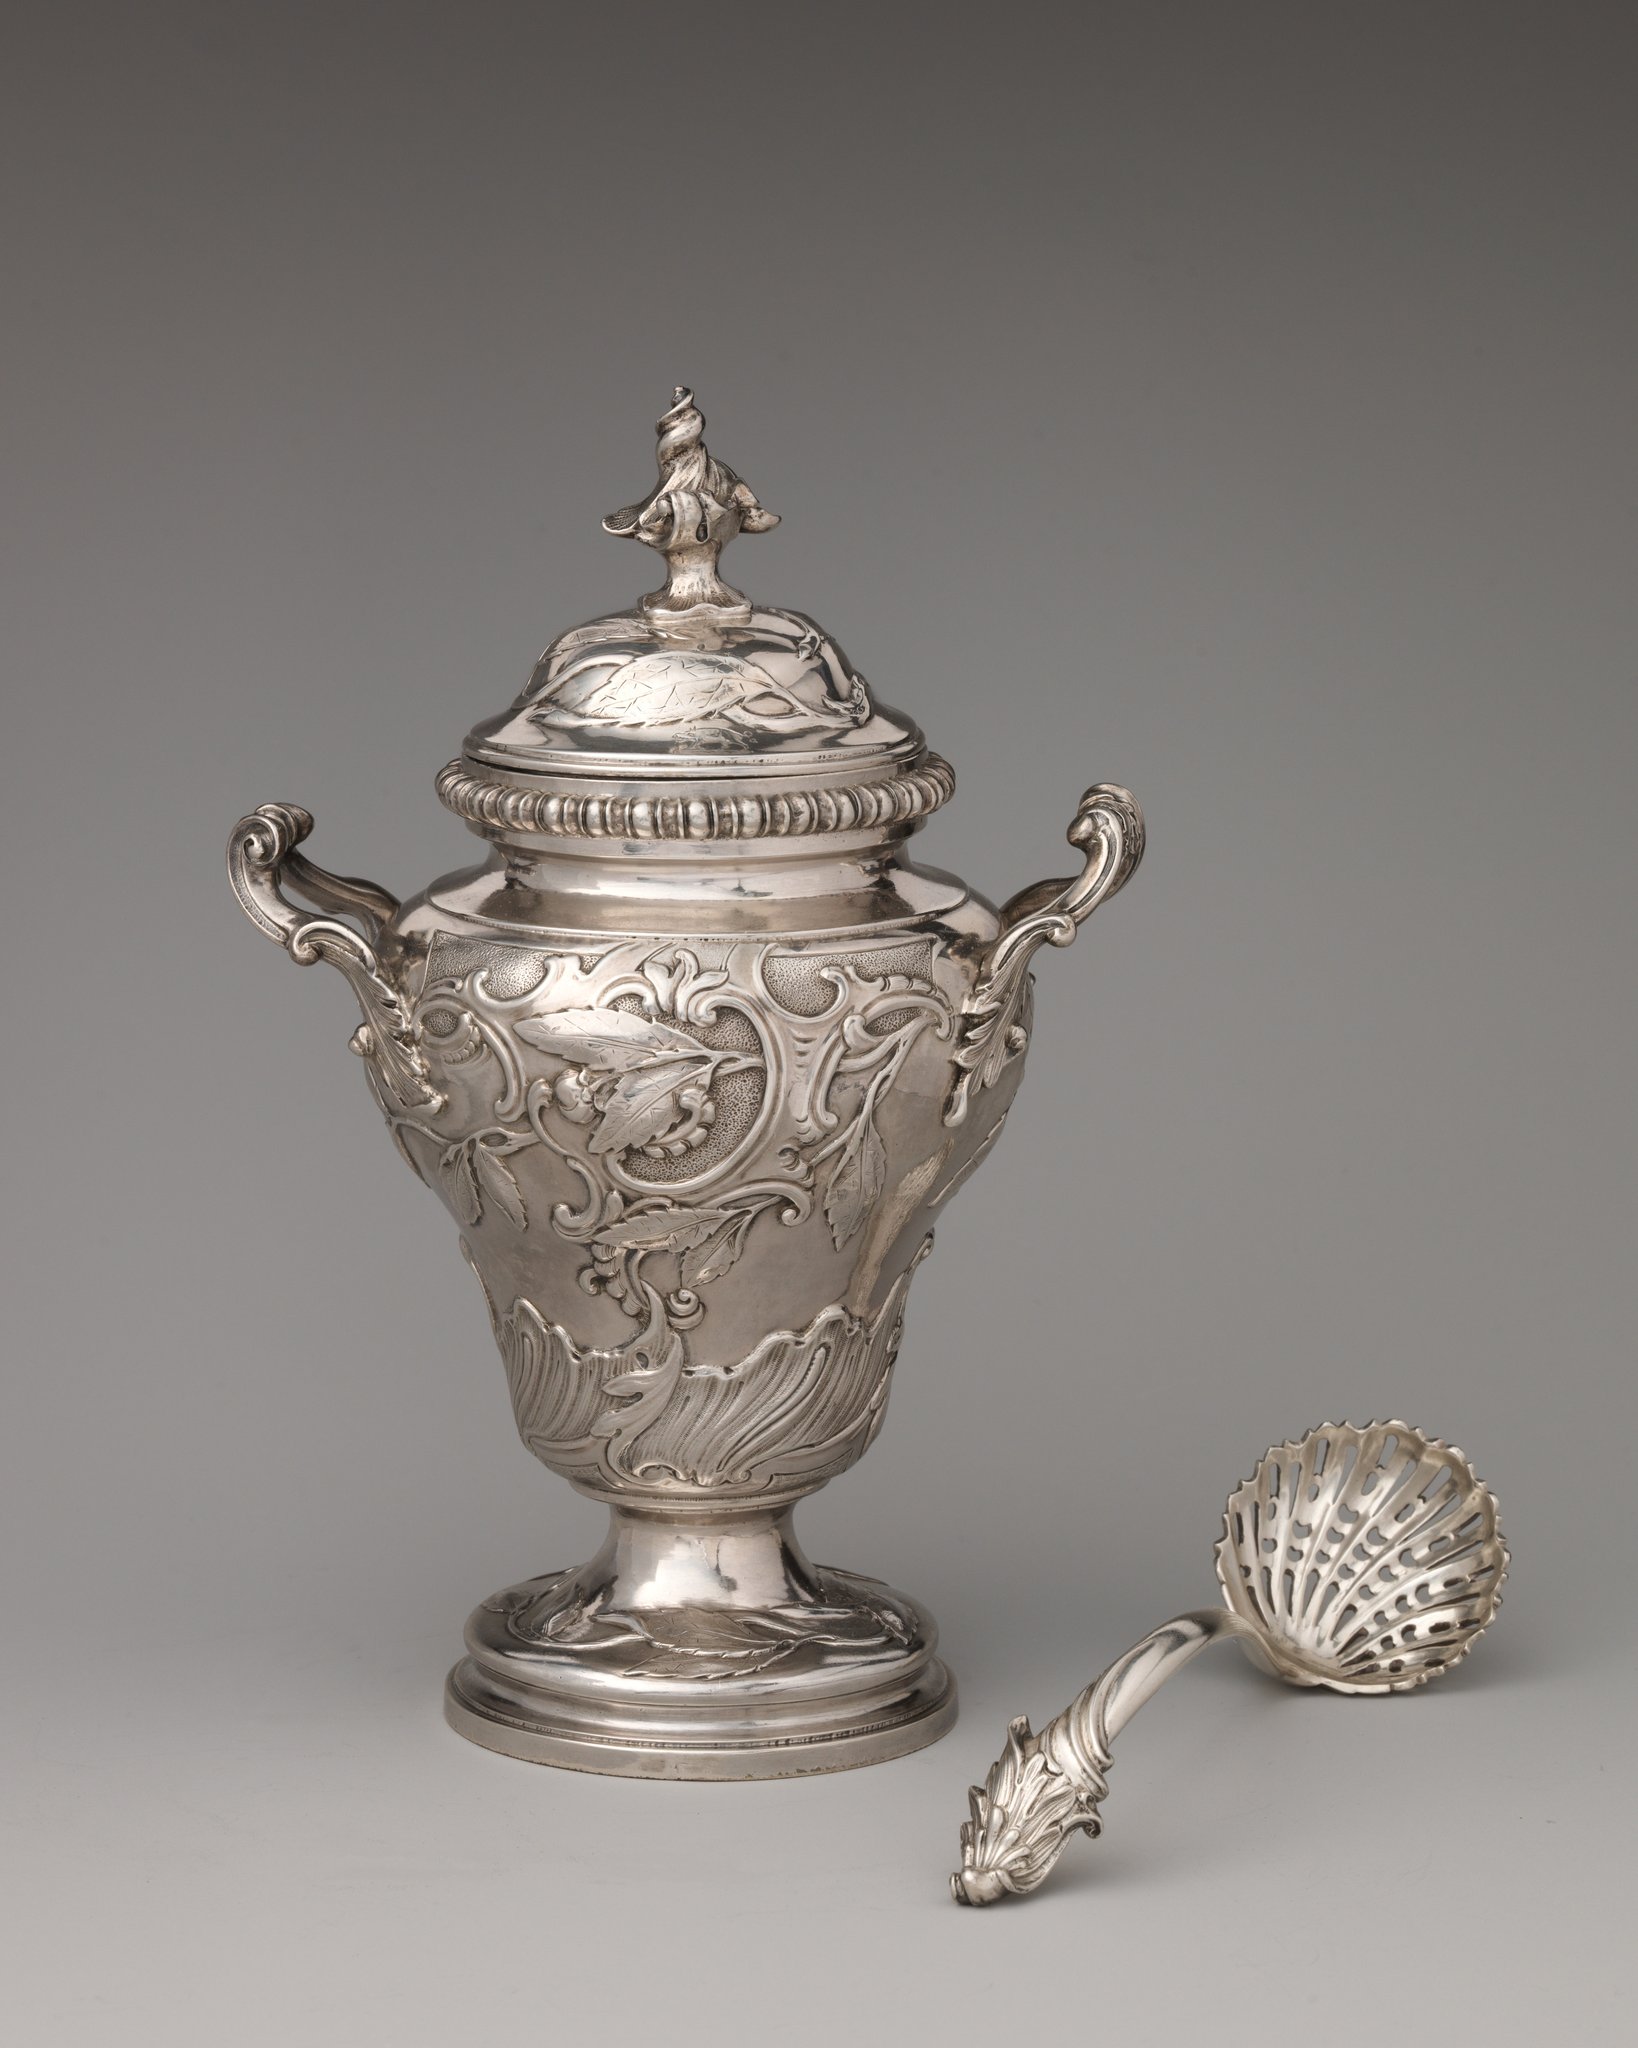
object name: tea caddy with spoon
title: Tea caddy with spoon (one of a set of three)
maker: john swift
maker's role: maker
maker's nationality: british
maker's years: 1728-1828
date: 1762-1763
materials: silver